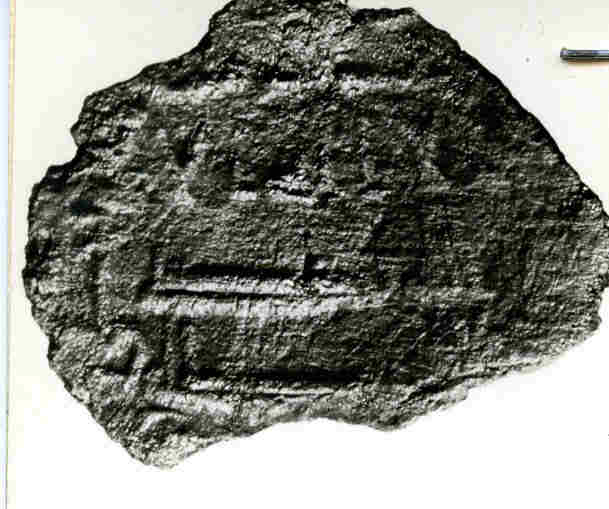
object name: coin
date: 701-833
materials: copper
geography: iran